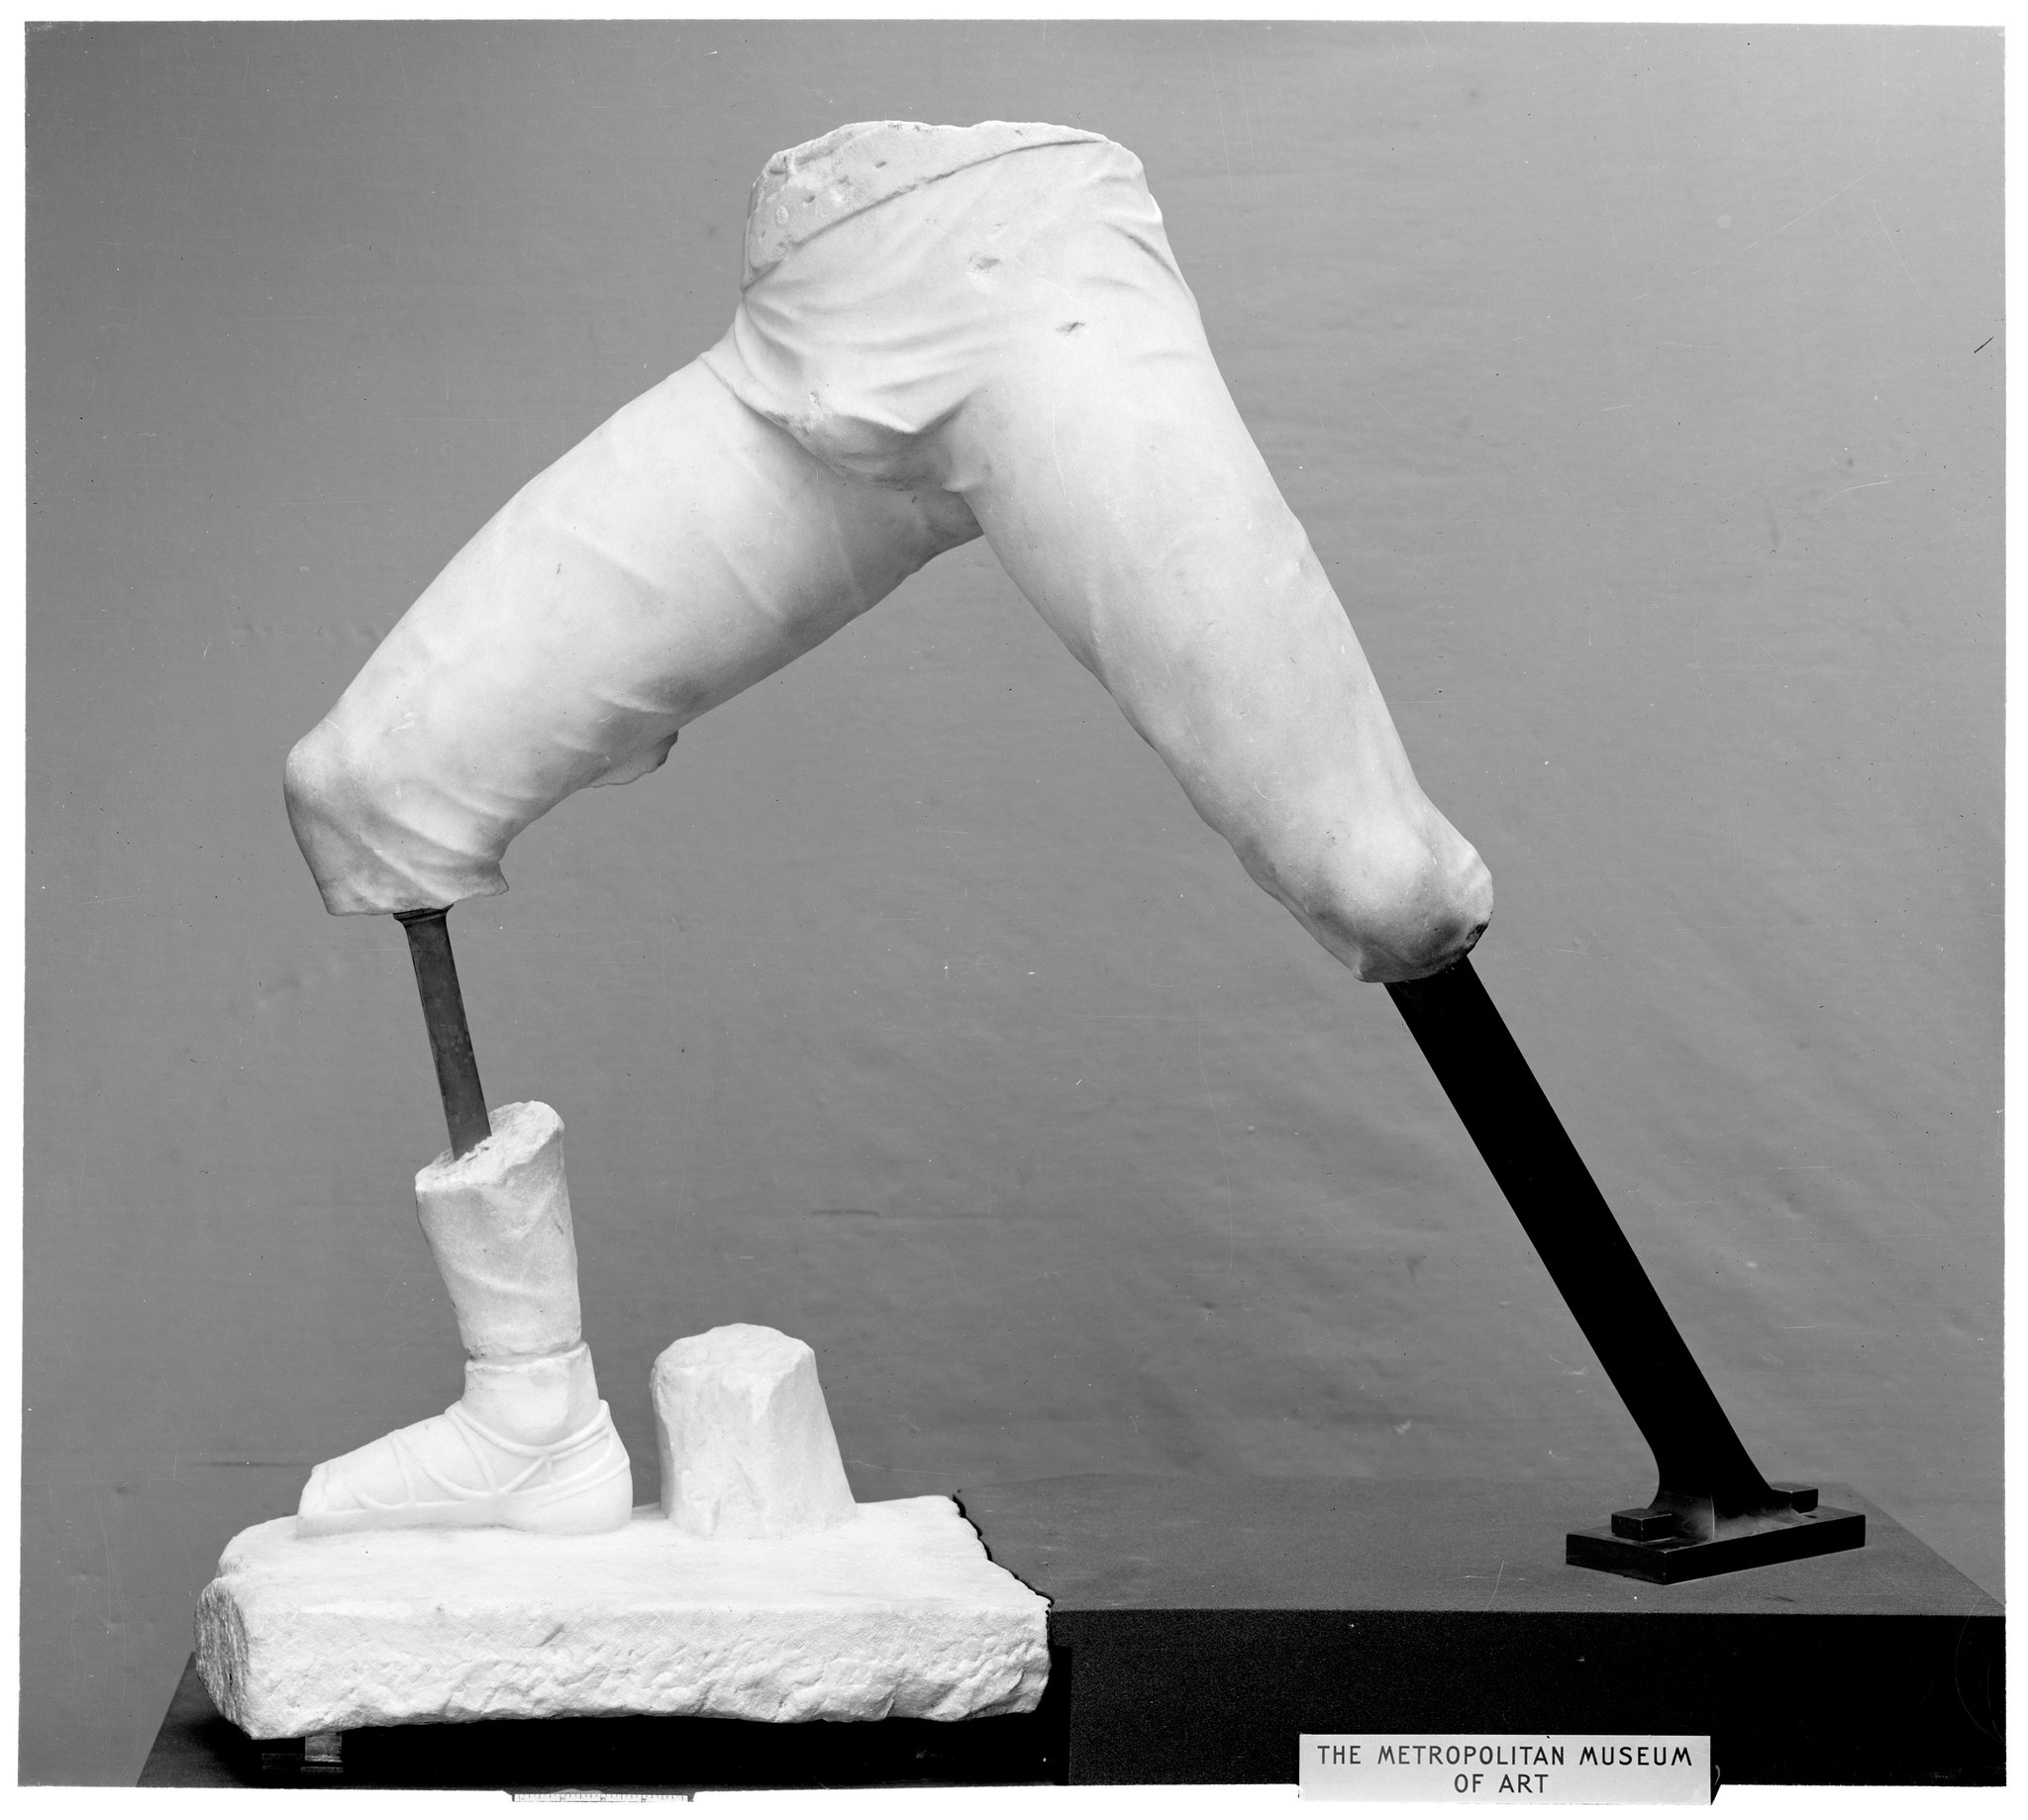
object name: statue of a fighting gaul, fragmentary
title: Marble statue of a fighting Gaul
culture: greek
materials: marble